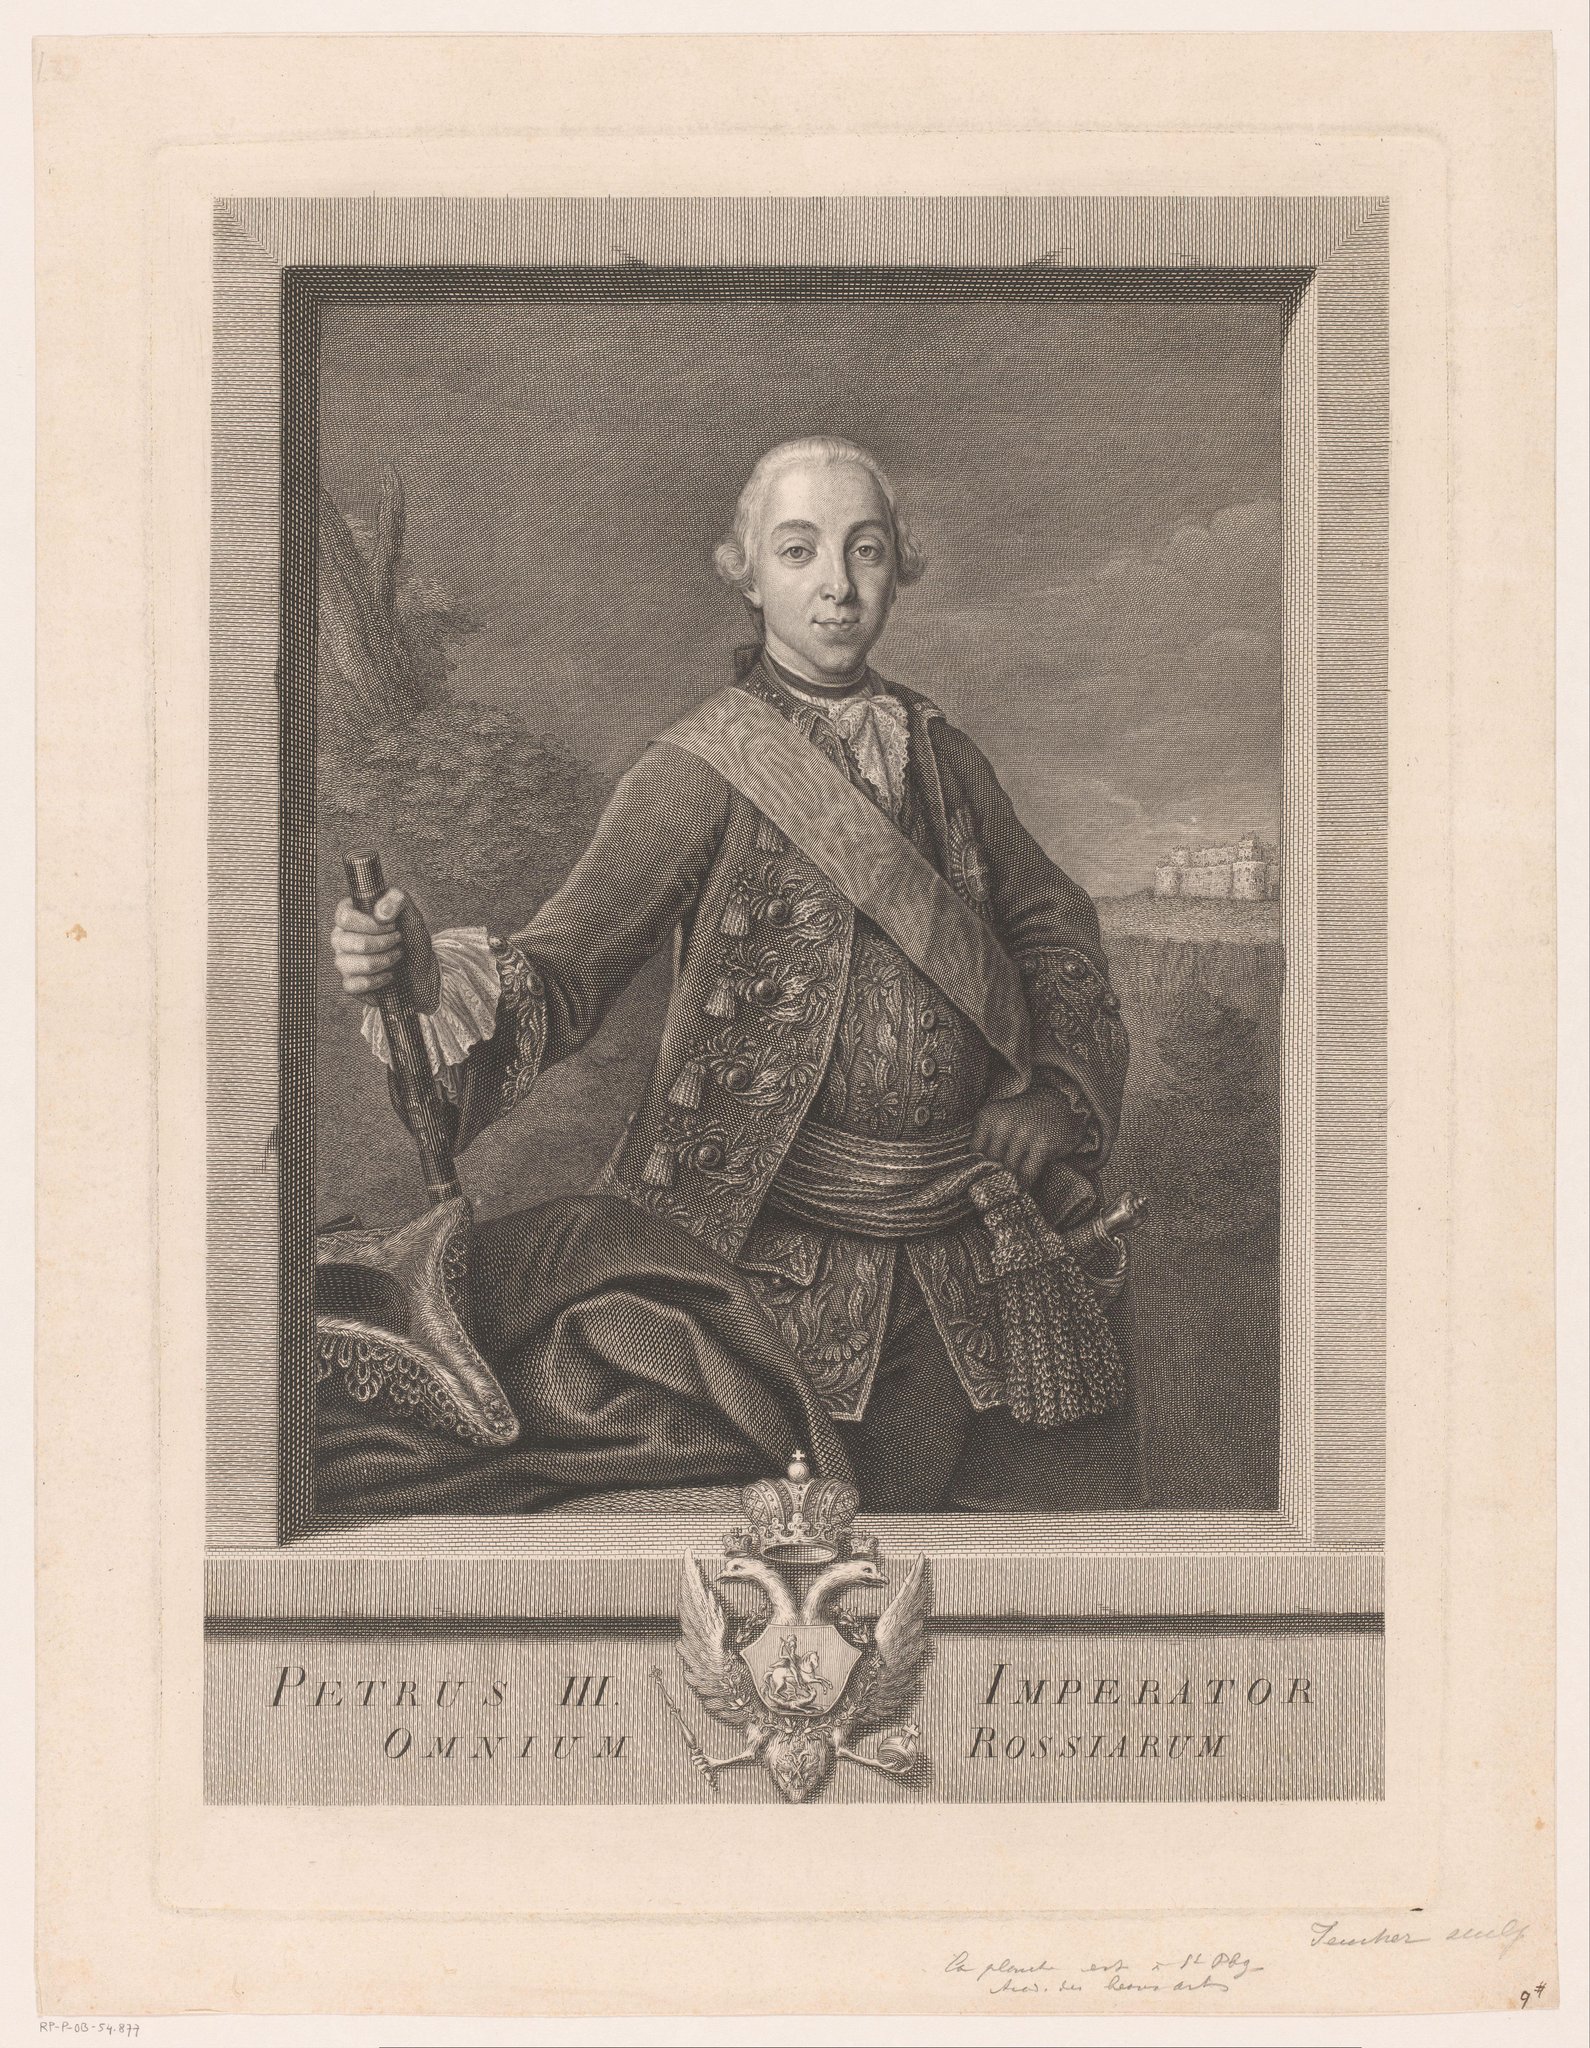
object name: print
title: Portret van Peter III van Rusland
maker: johann christoph teucher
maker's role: print maker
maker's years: 1715-1763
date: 1762-1763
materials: paper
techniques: engraving, etching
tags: castle, historical persons, baton of general, armorial bearing, heraldry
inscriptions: collector's mark: Lugt 240